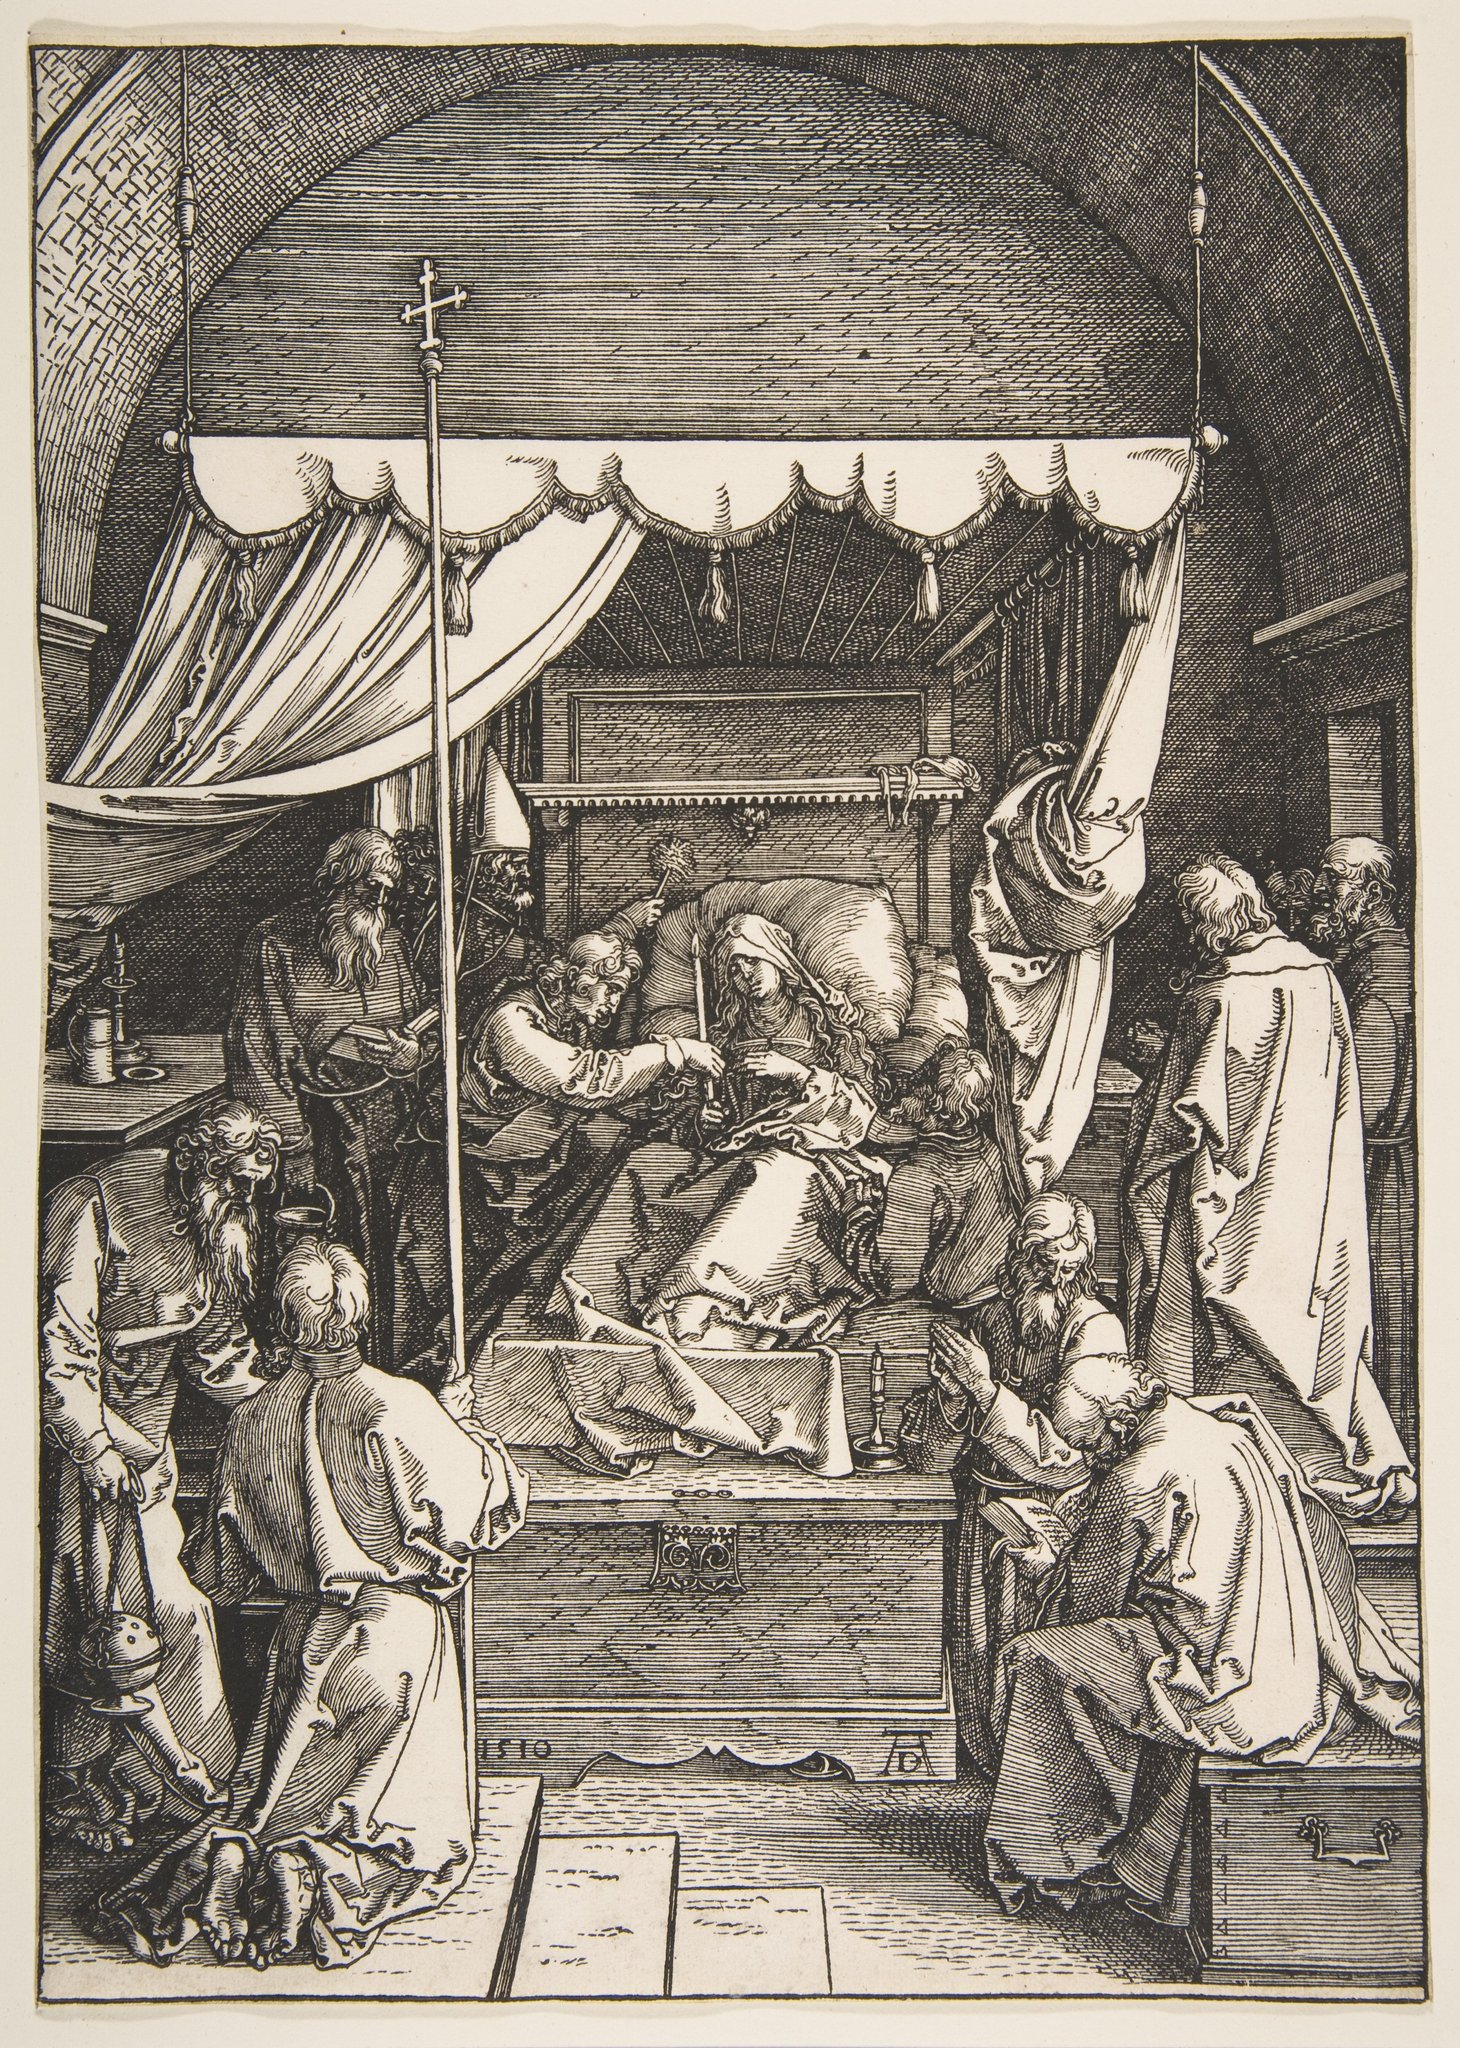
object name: print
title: The Death of the Virgin, from "The Life of the Virgin"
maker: albrecht dürer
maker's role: artist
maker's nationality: german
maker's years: 1471-1528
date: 1510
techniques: woodcut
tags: men,virgin mary